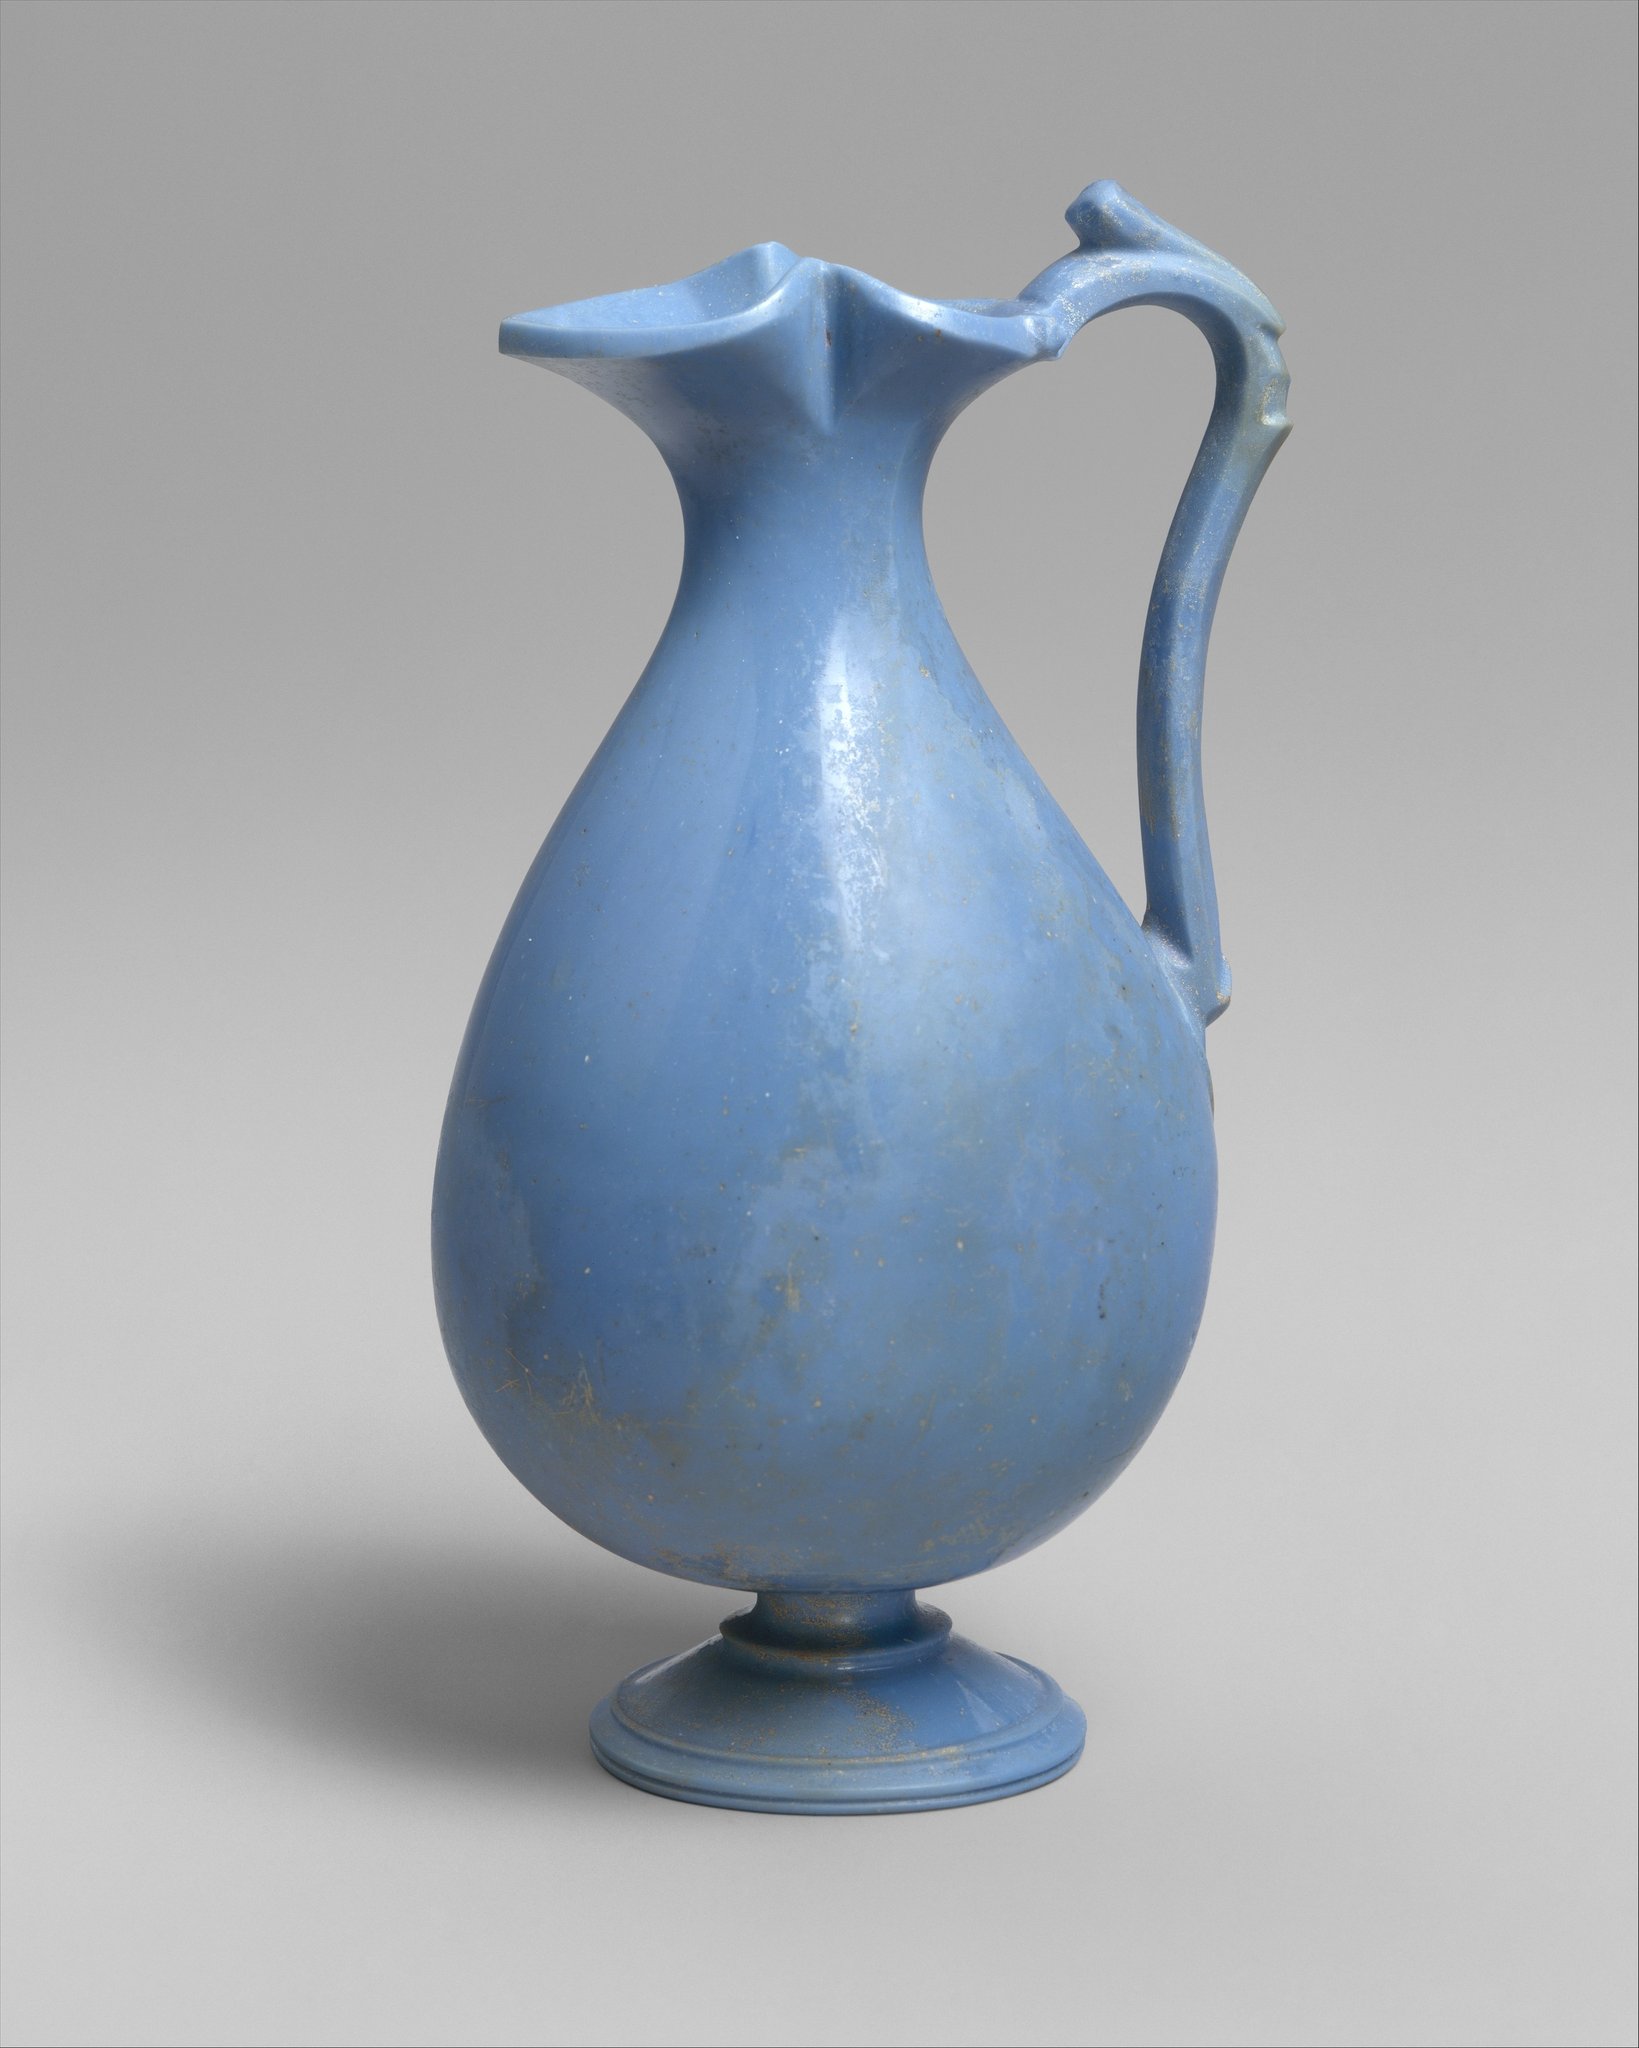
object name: oinochoe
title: Glass oinochoe (jug)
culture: roman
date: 34 BCE-33 CE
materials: glass